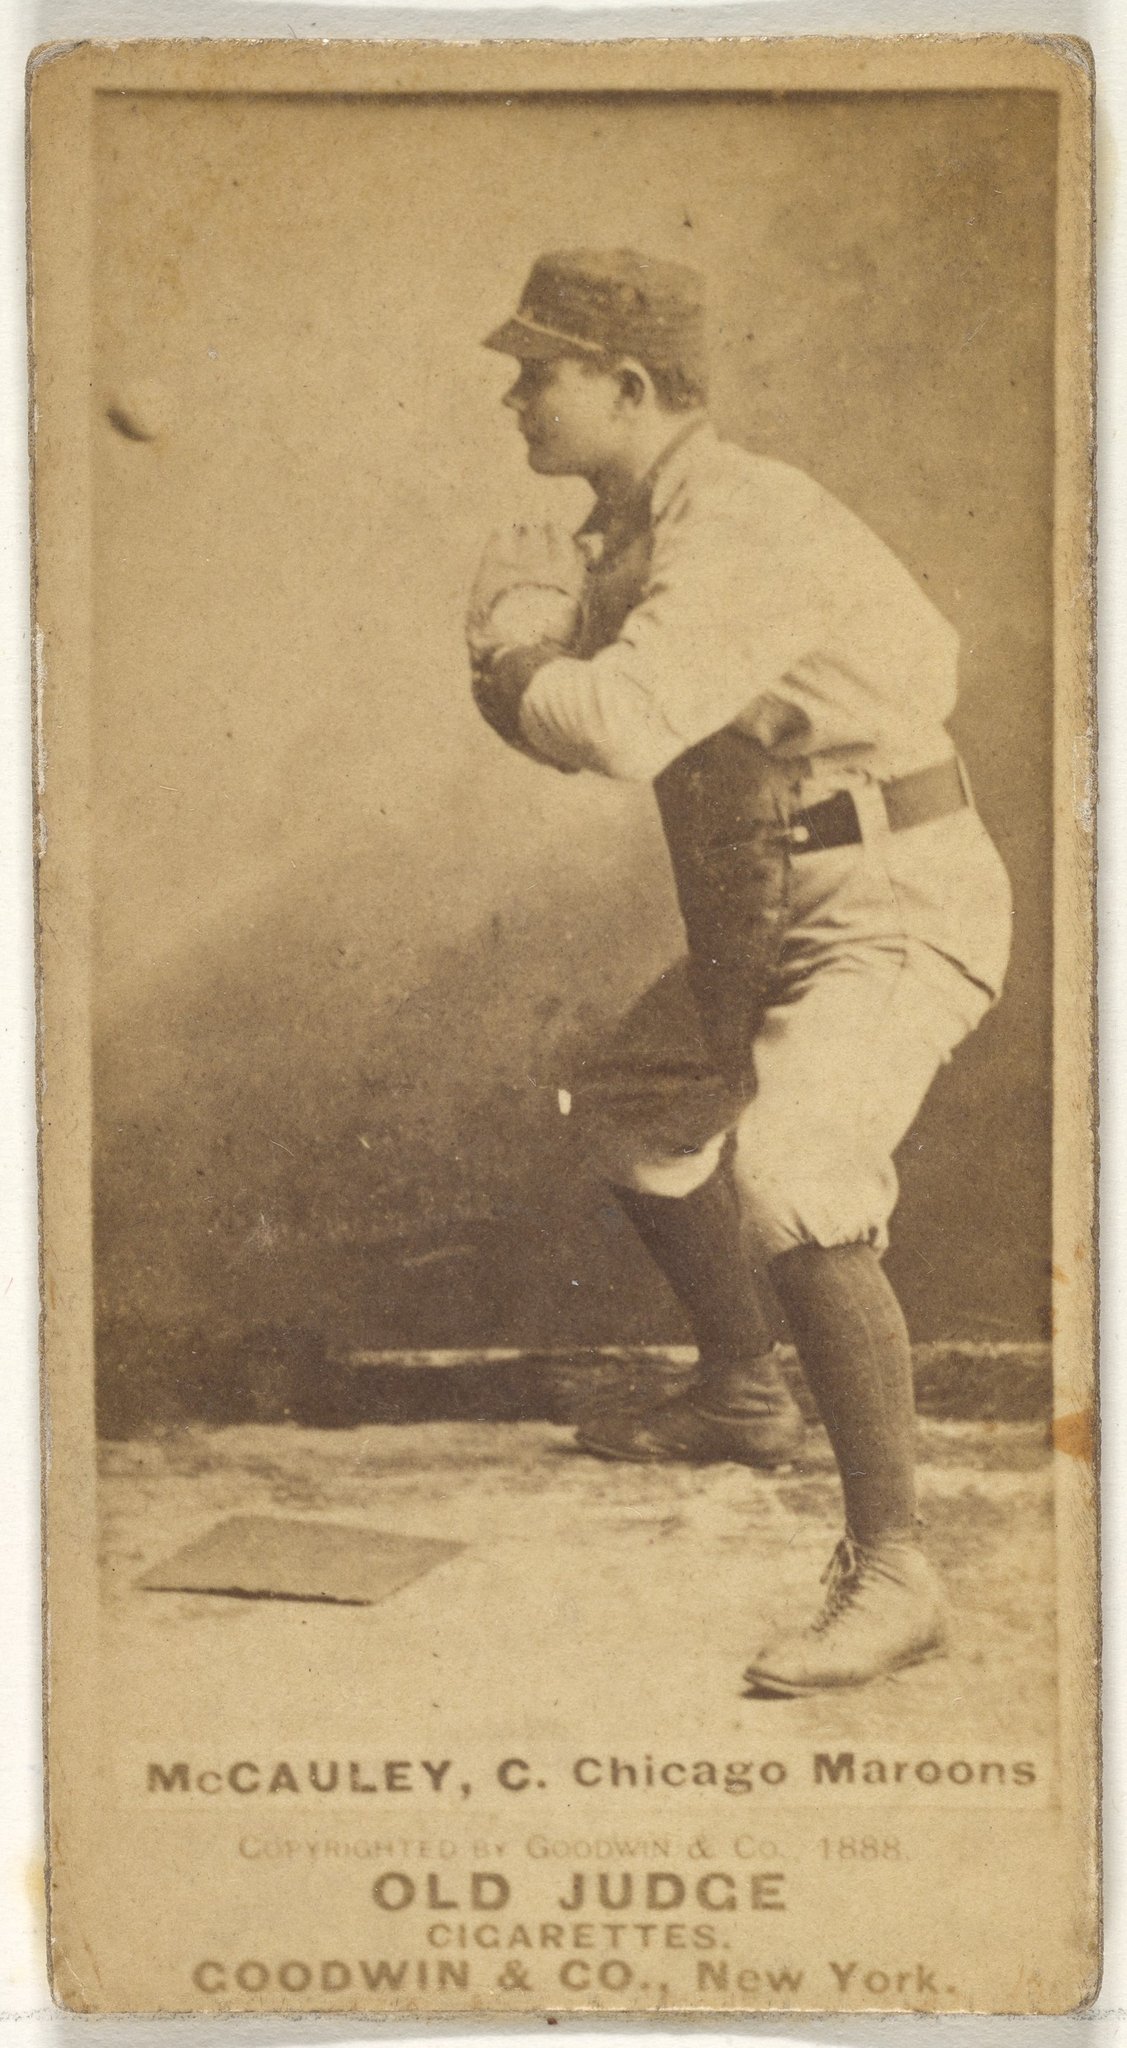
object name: baseball card, photograph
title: McCauley, Catcher, Chicago, from the Old Judge series (N172) for Old Judge Cigarettes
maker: goodwin & company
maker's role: publisher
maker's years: 1850-1950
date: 1888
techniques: albumen silver print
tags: men,portraits,baseball,athletes